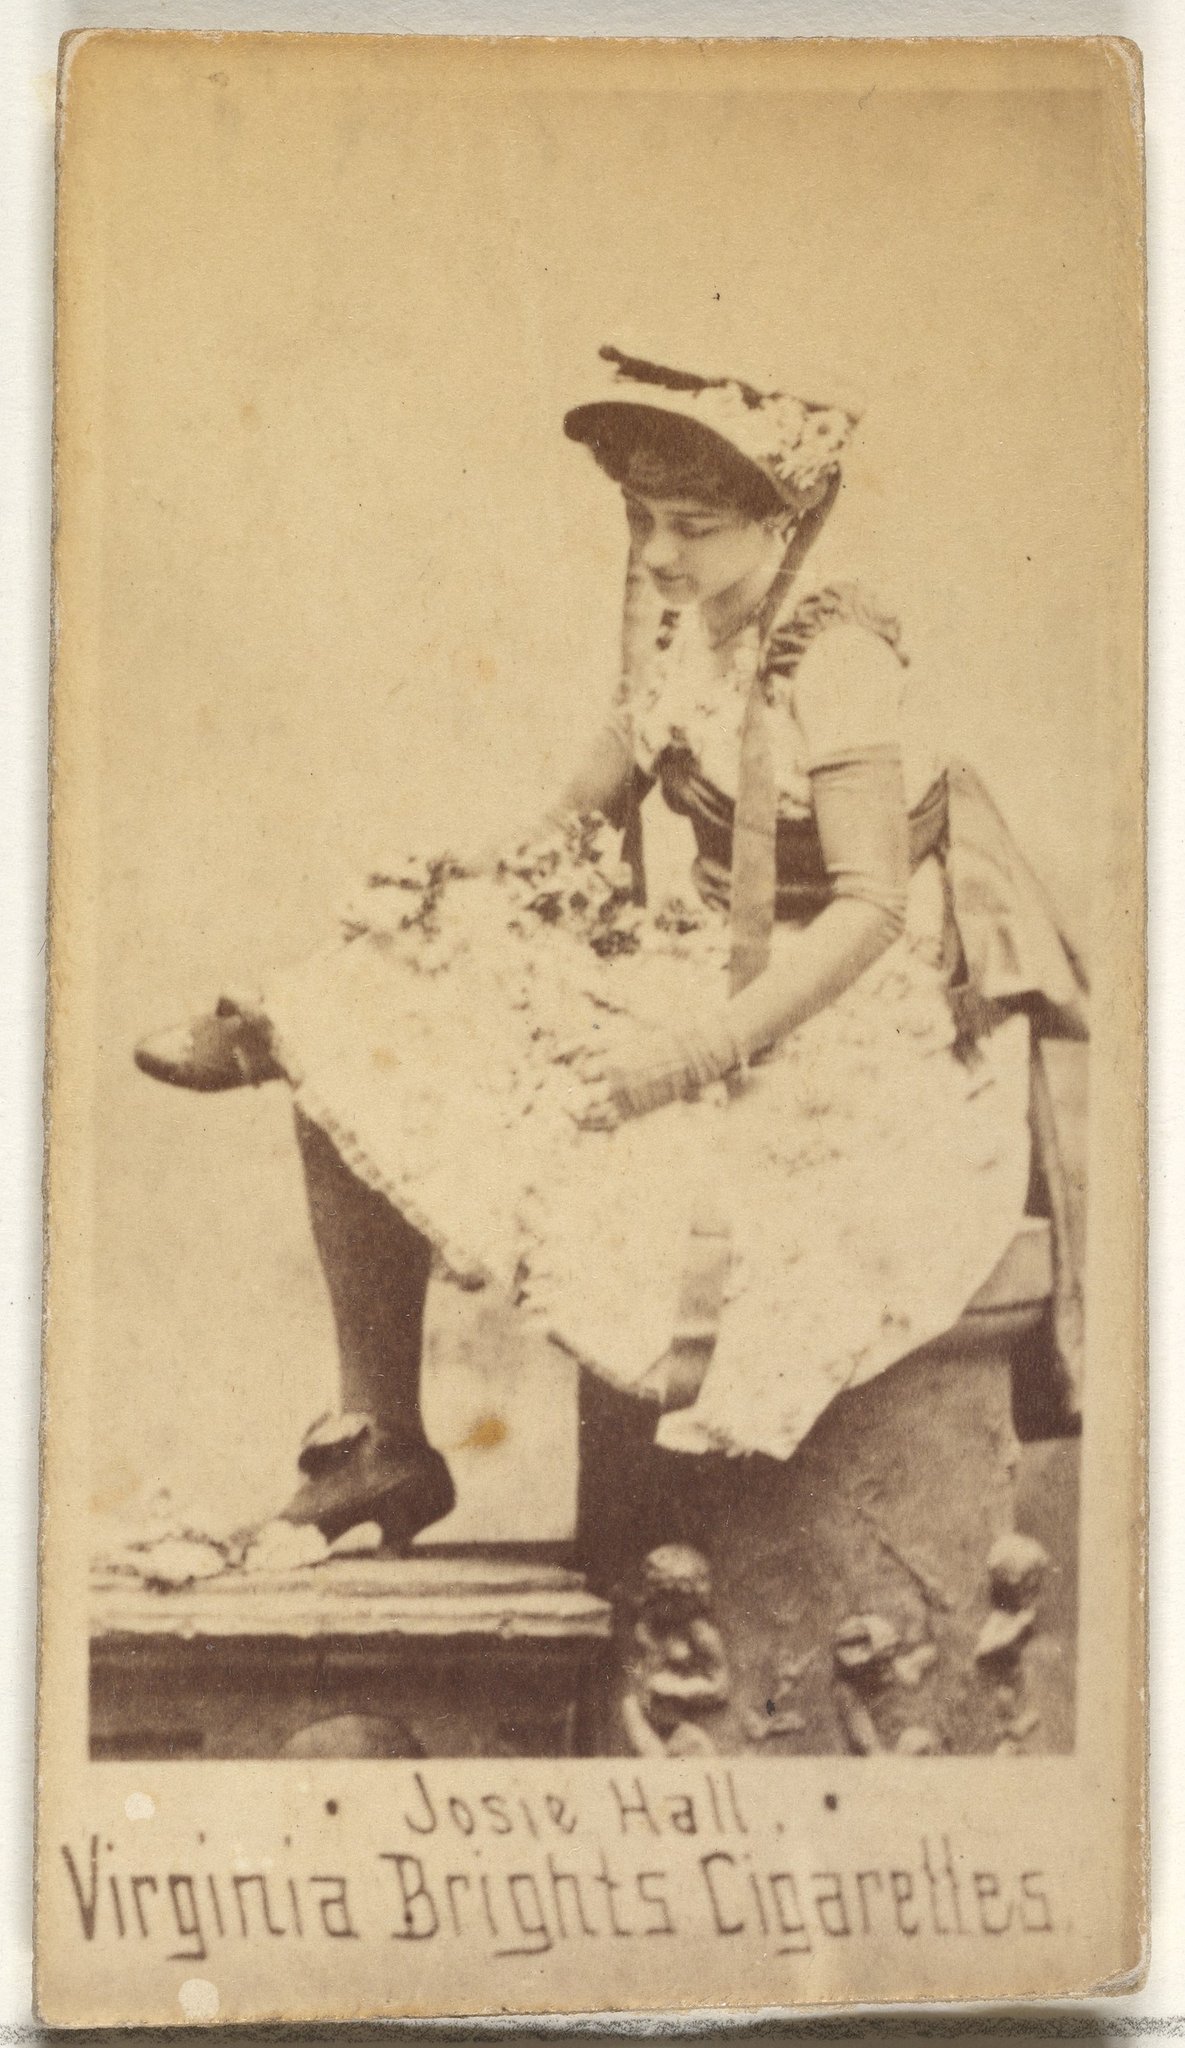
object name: photograph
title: Josie Hall, from the Actors and Actresses series (N45, Type 1) for Virginia Brights Cigarettes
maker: allen & ginter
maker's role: publisher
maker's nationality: american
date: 1888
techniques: albumen silver print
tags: portraits,women,actresses